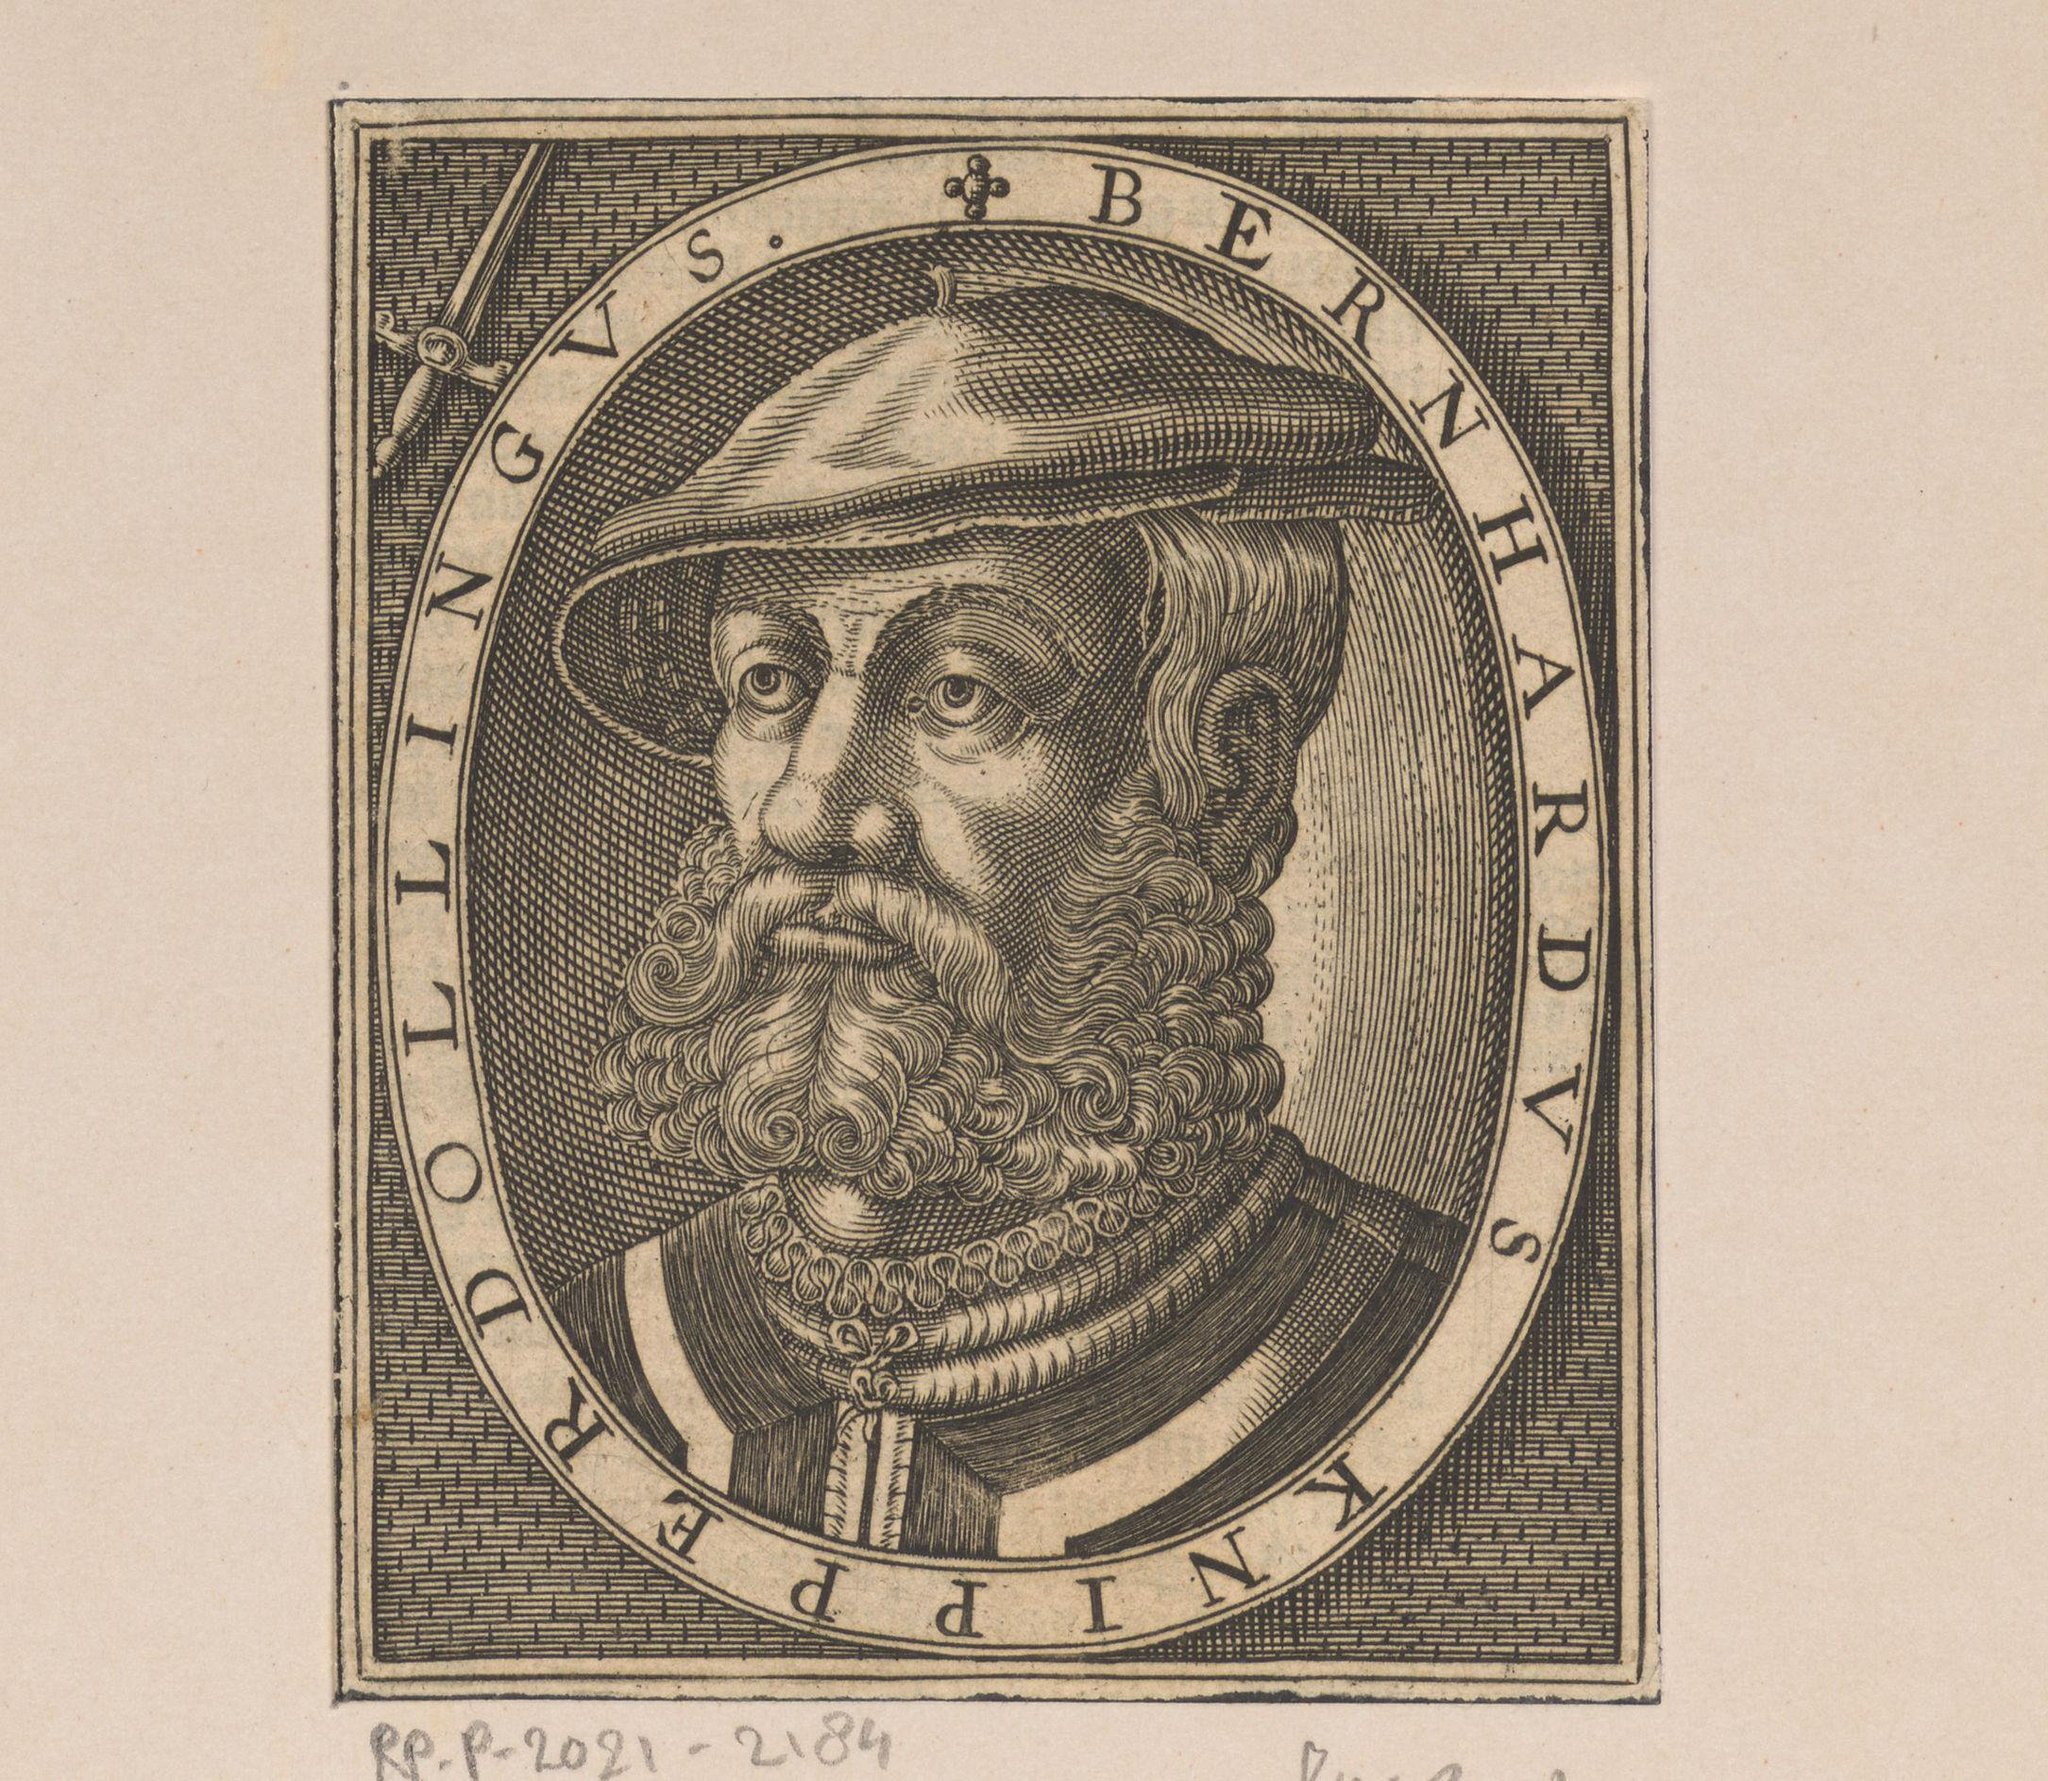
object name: print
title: Portret van Bernardus Knipperdolling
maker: Anonymous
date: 1590-1699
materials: paper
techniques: engraving, letterpress printing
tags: historical persons